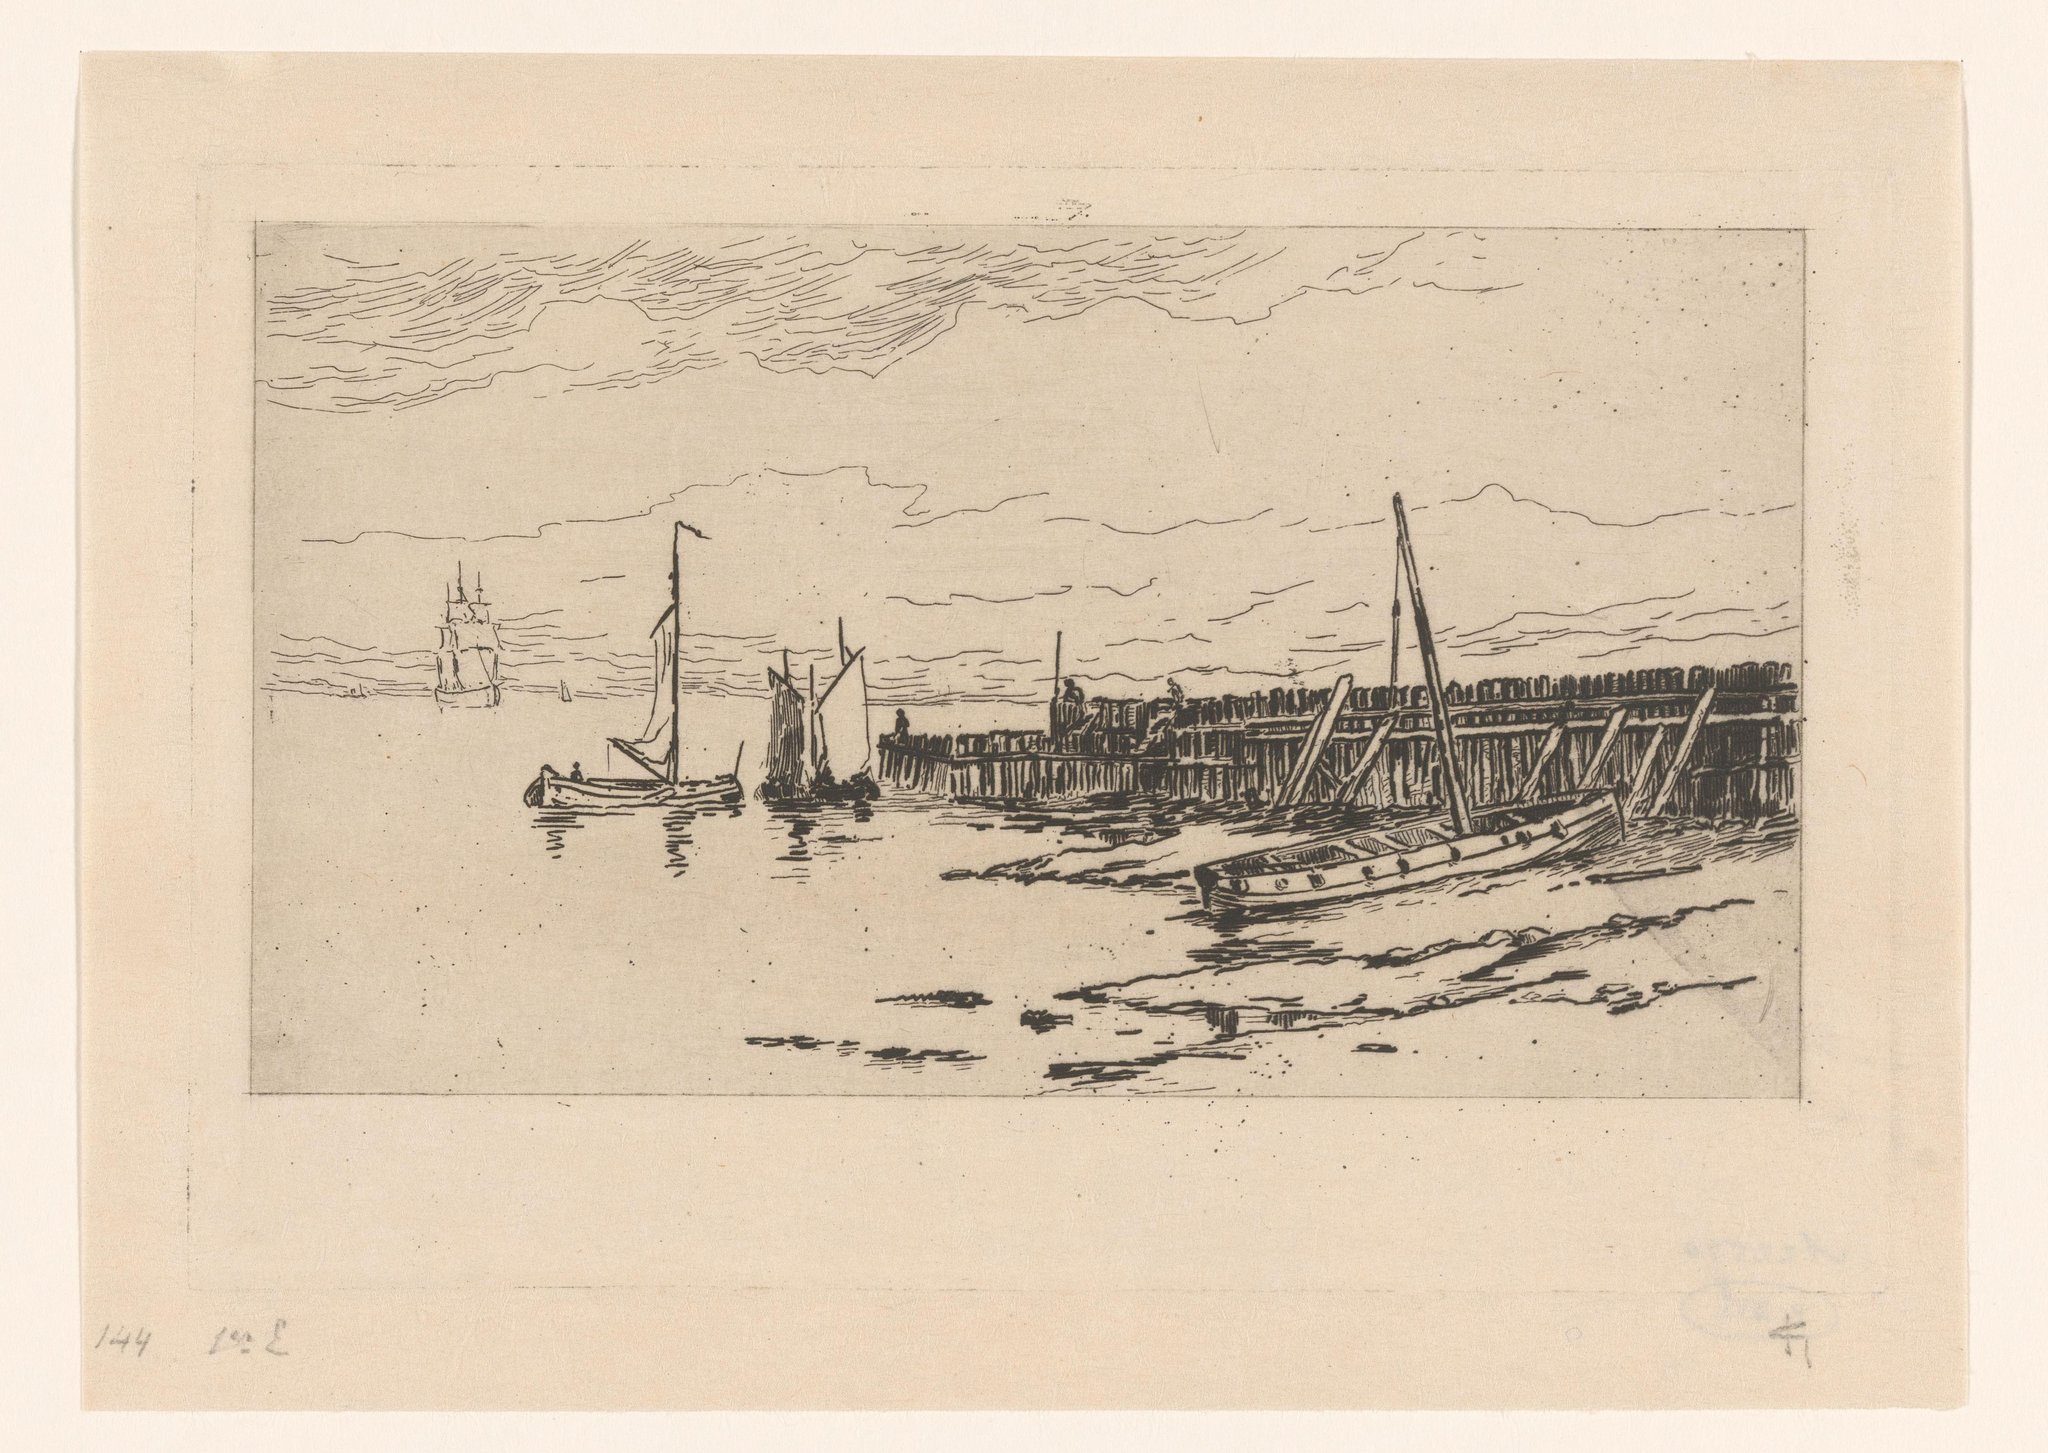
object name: print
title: Havenhoofd in Vlissingen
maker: carel nicolaas storm van s-gravesande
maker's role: draughtsman, print maker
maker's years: 1841-1924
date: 1880-1884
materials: paper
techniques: etching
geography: netherlands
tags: pier, quay, wharf, flushing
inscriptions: collector's mark: Lugt 2228